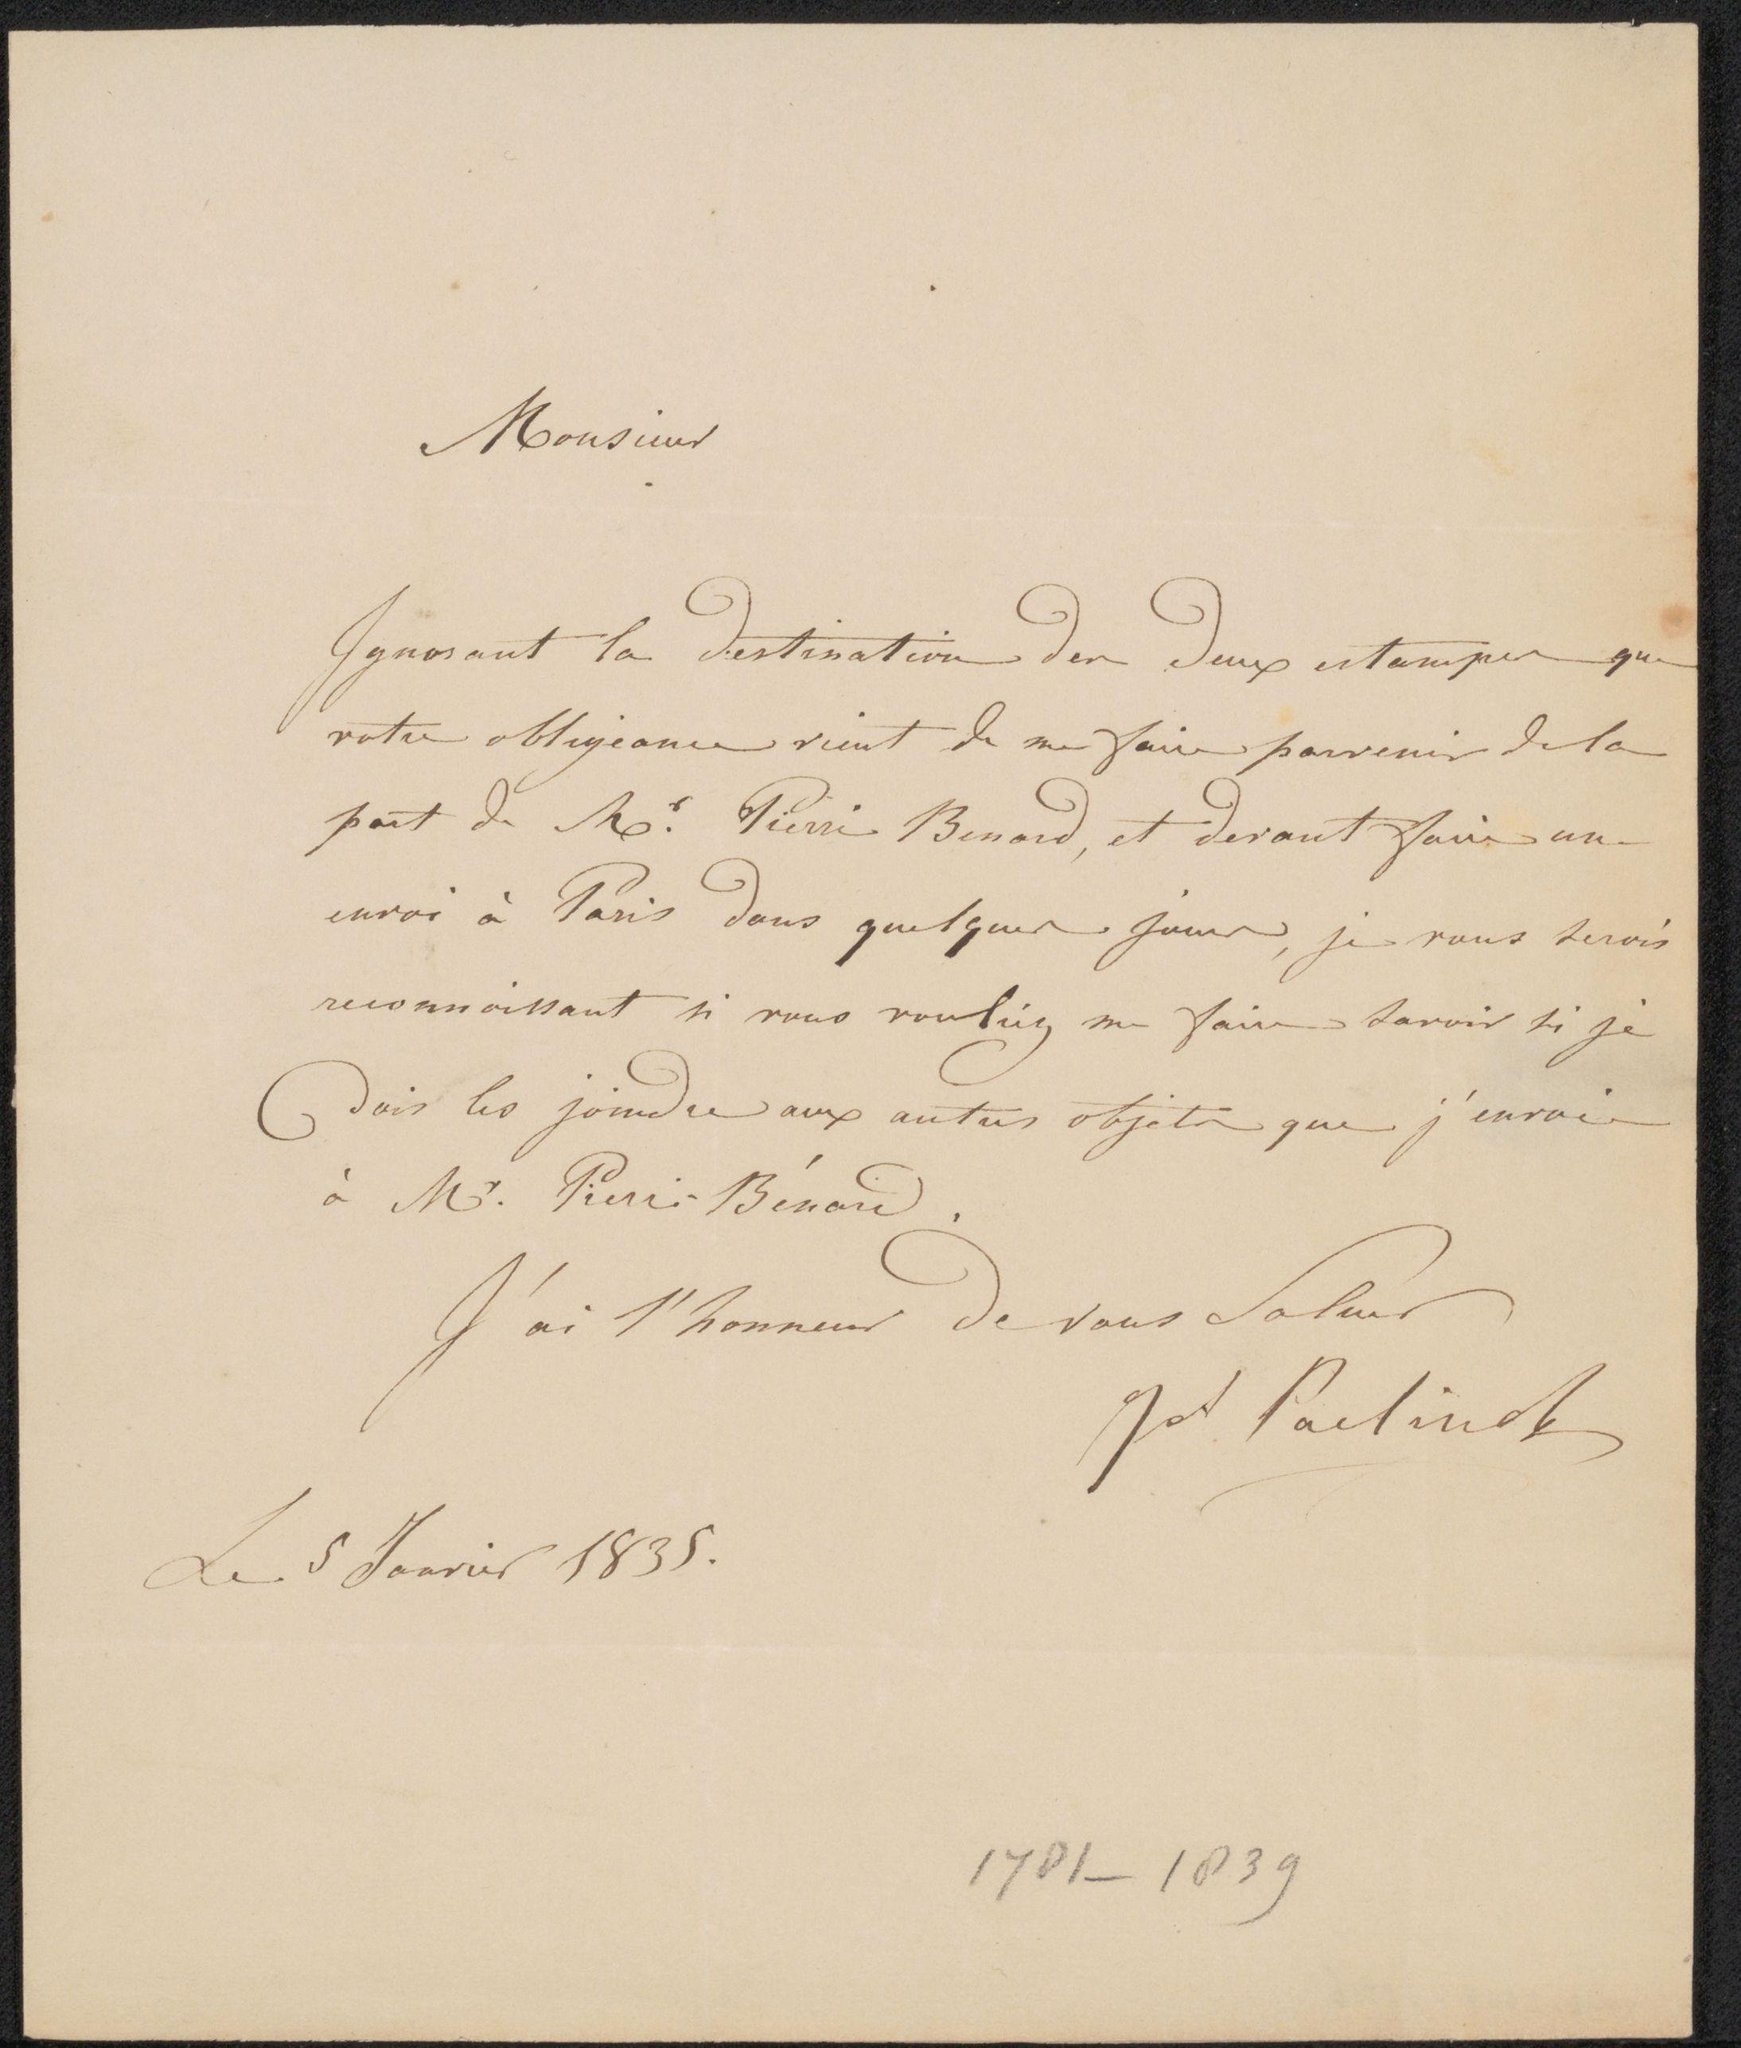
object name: letter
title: Brief aan de heer Cambertyn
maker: joseph paelinck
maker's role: painter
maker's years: 1781-1839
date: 1835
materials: ink, paper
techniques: pen, writing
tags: paris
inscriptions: watermark